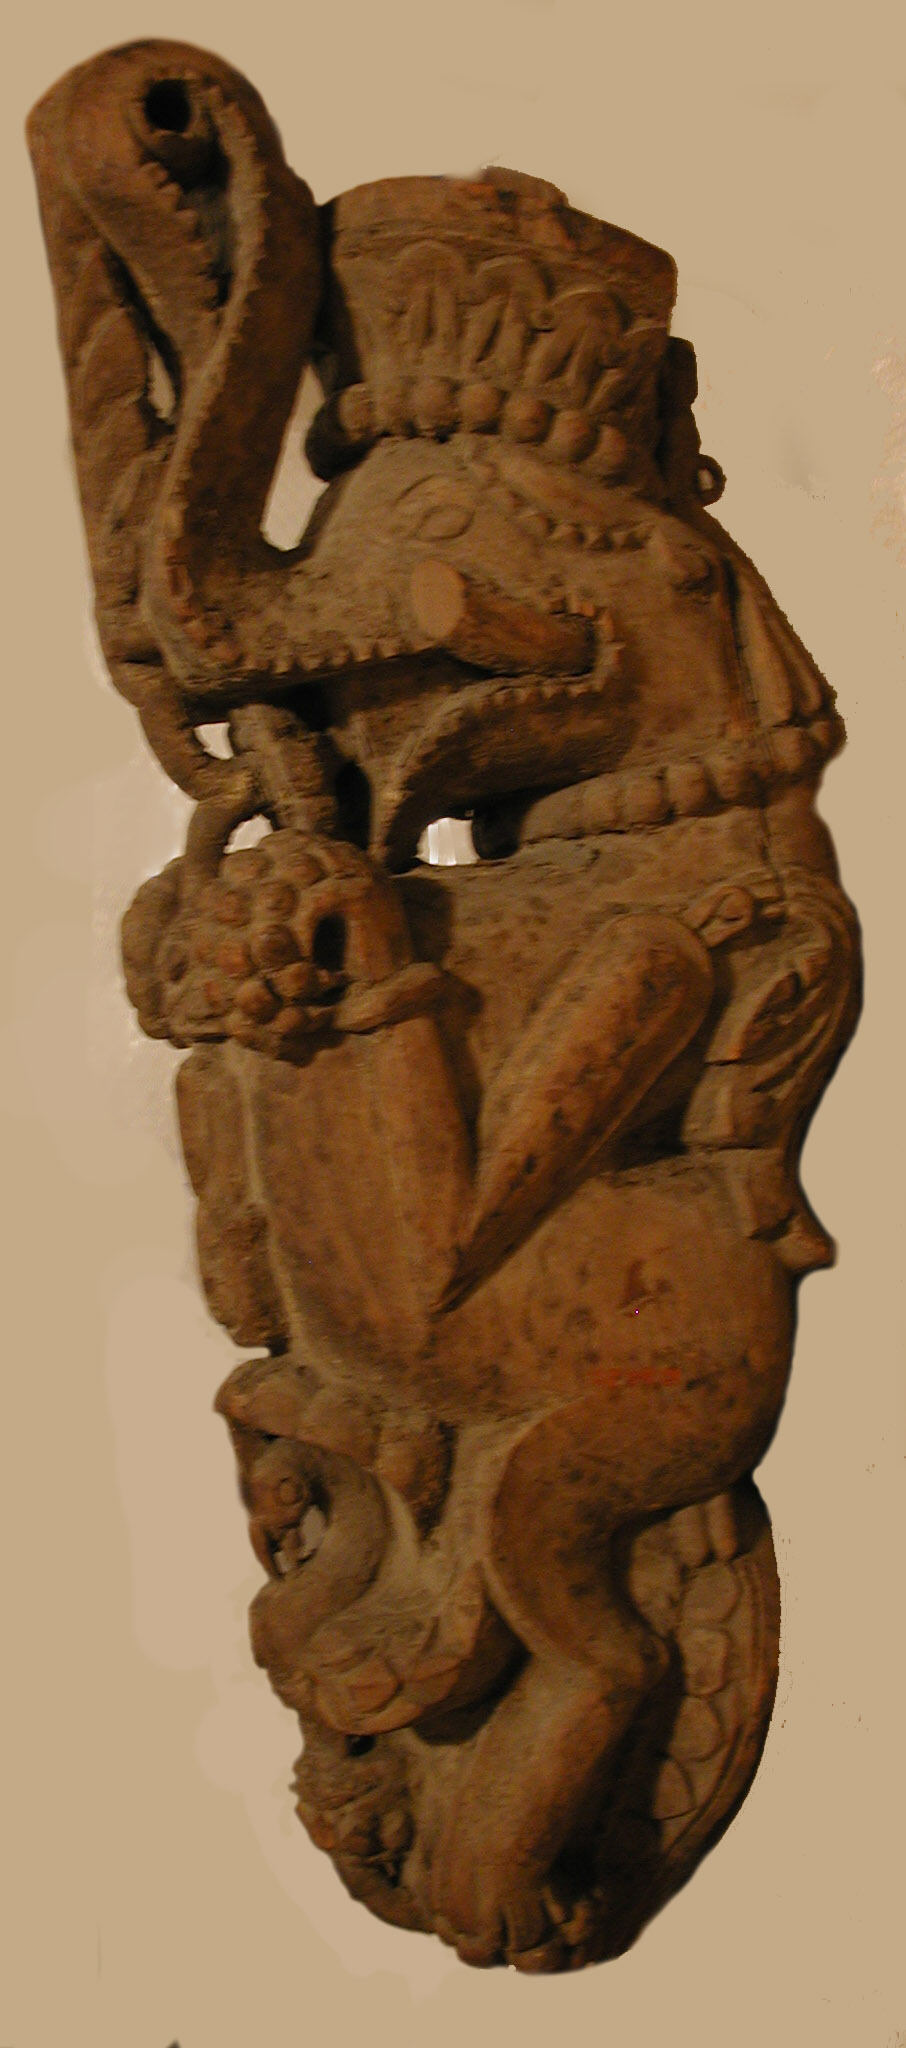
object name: bracket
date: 1701-1800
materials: wood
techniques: carving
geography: india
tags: elephants